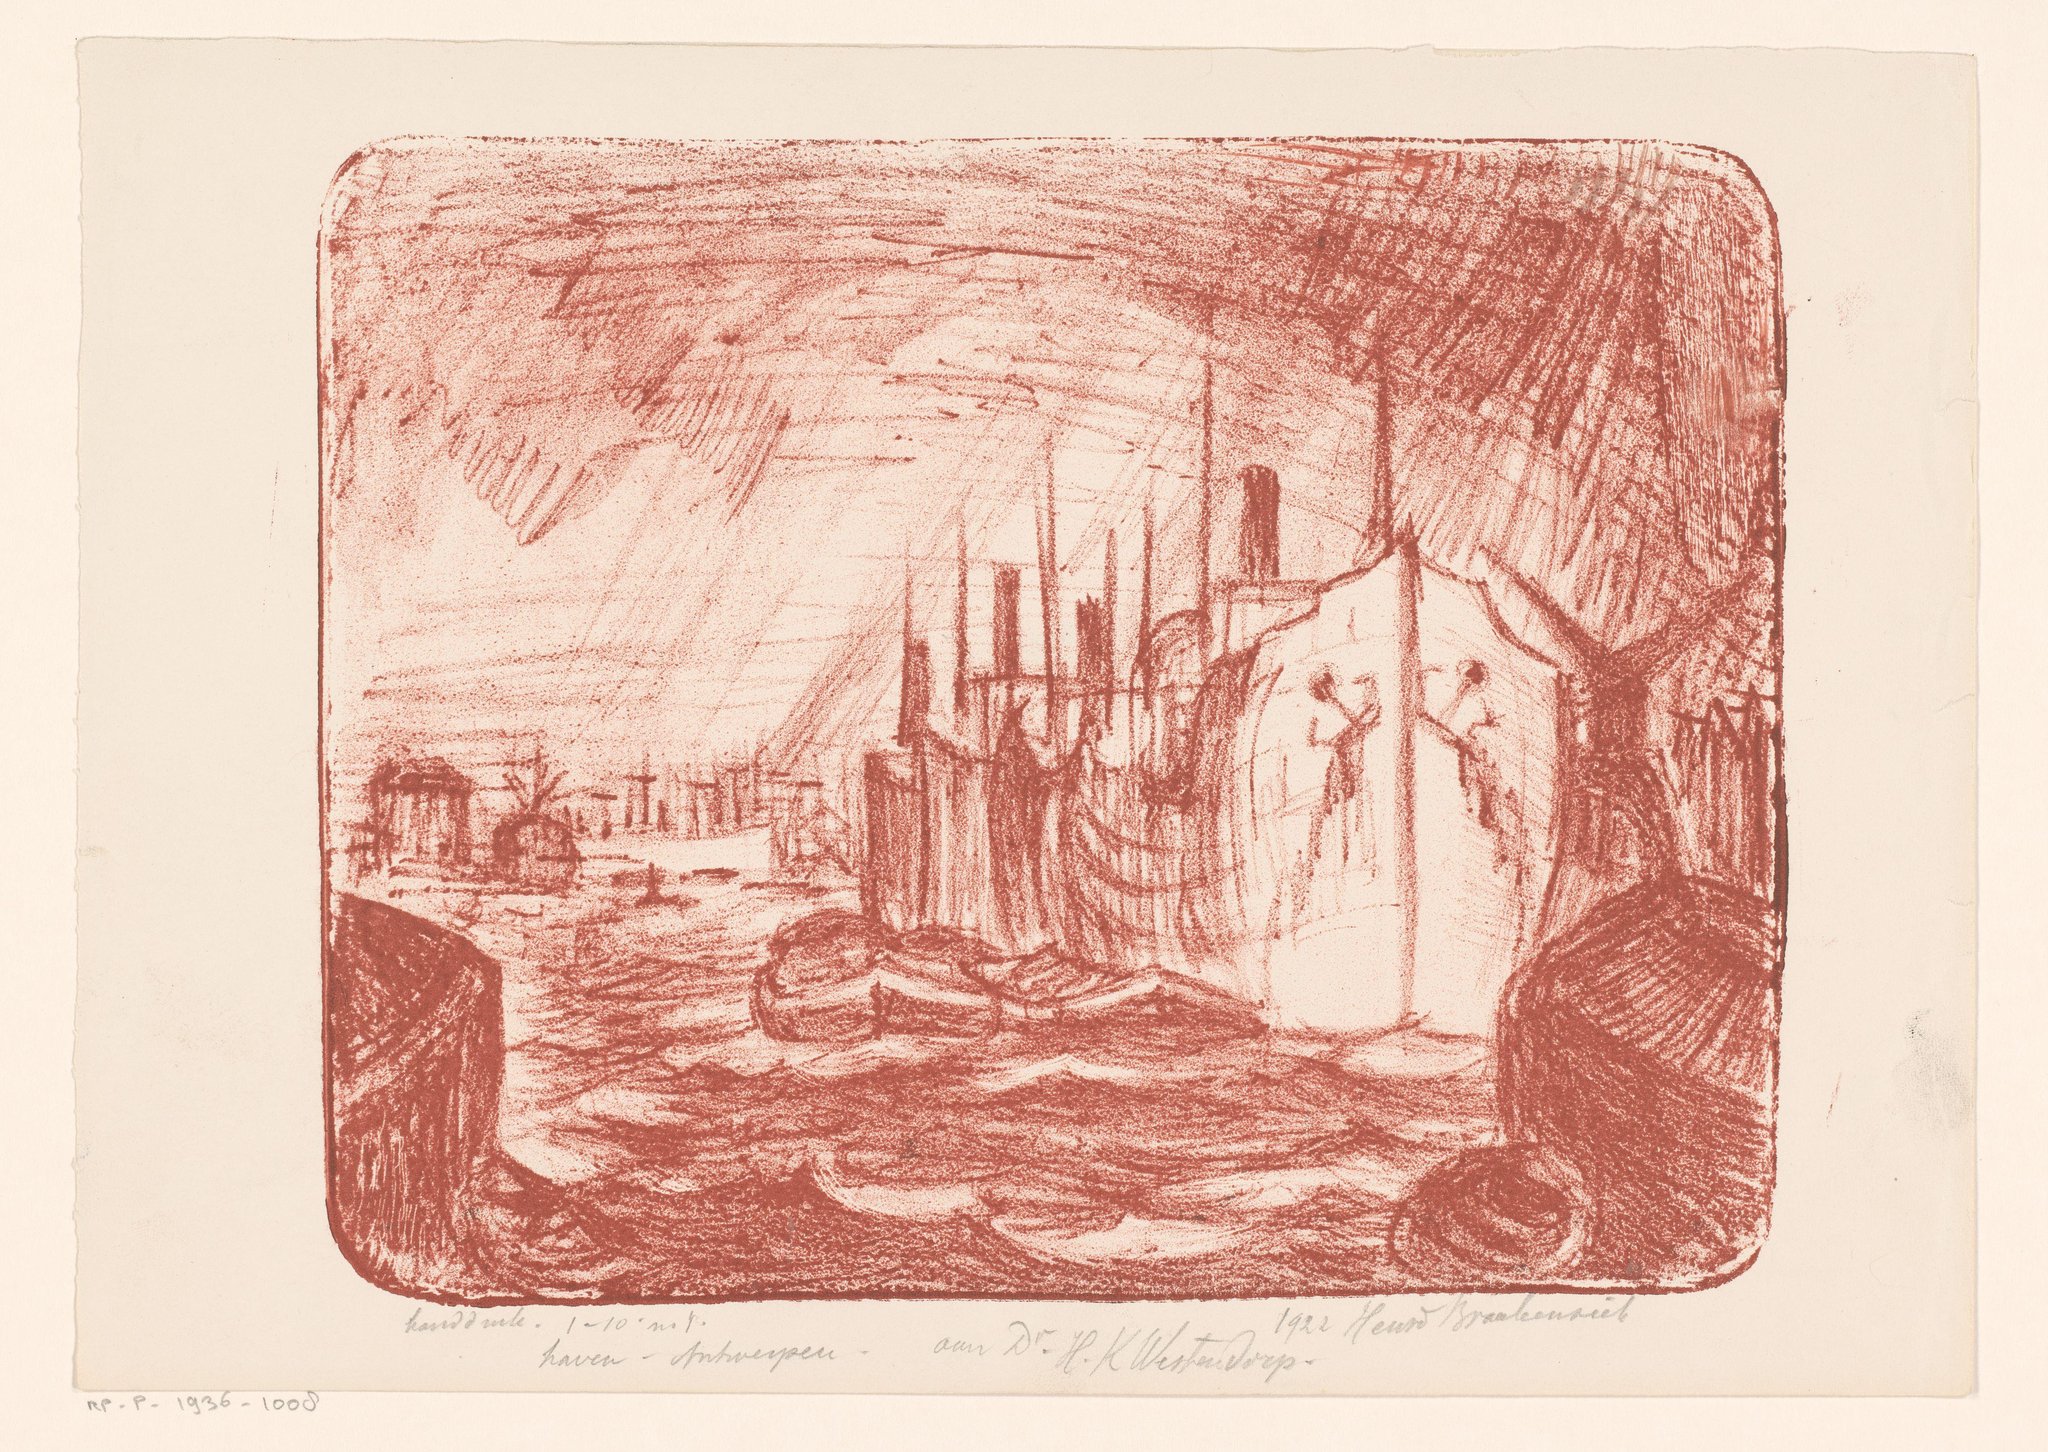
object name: print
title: Haven van Antwerpen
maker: henri braakensiek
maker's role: print maker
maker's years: 1891-1941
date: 1922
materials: paper, ink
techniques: lithograph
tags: harbour, antwerp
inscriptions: dedication: ‘aan Dr. H.K. Westendorp.’, collector's mark: Lugt 2228, edition: ‘handdruk 1-10’, signature and date: ‘1922 Henri Braakensiek’, title: ‘haven - Antwerpen -’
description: Aangemeerde schepen in woelend water; schetsmatig weergegeven.